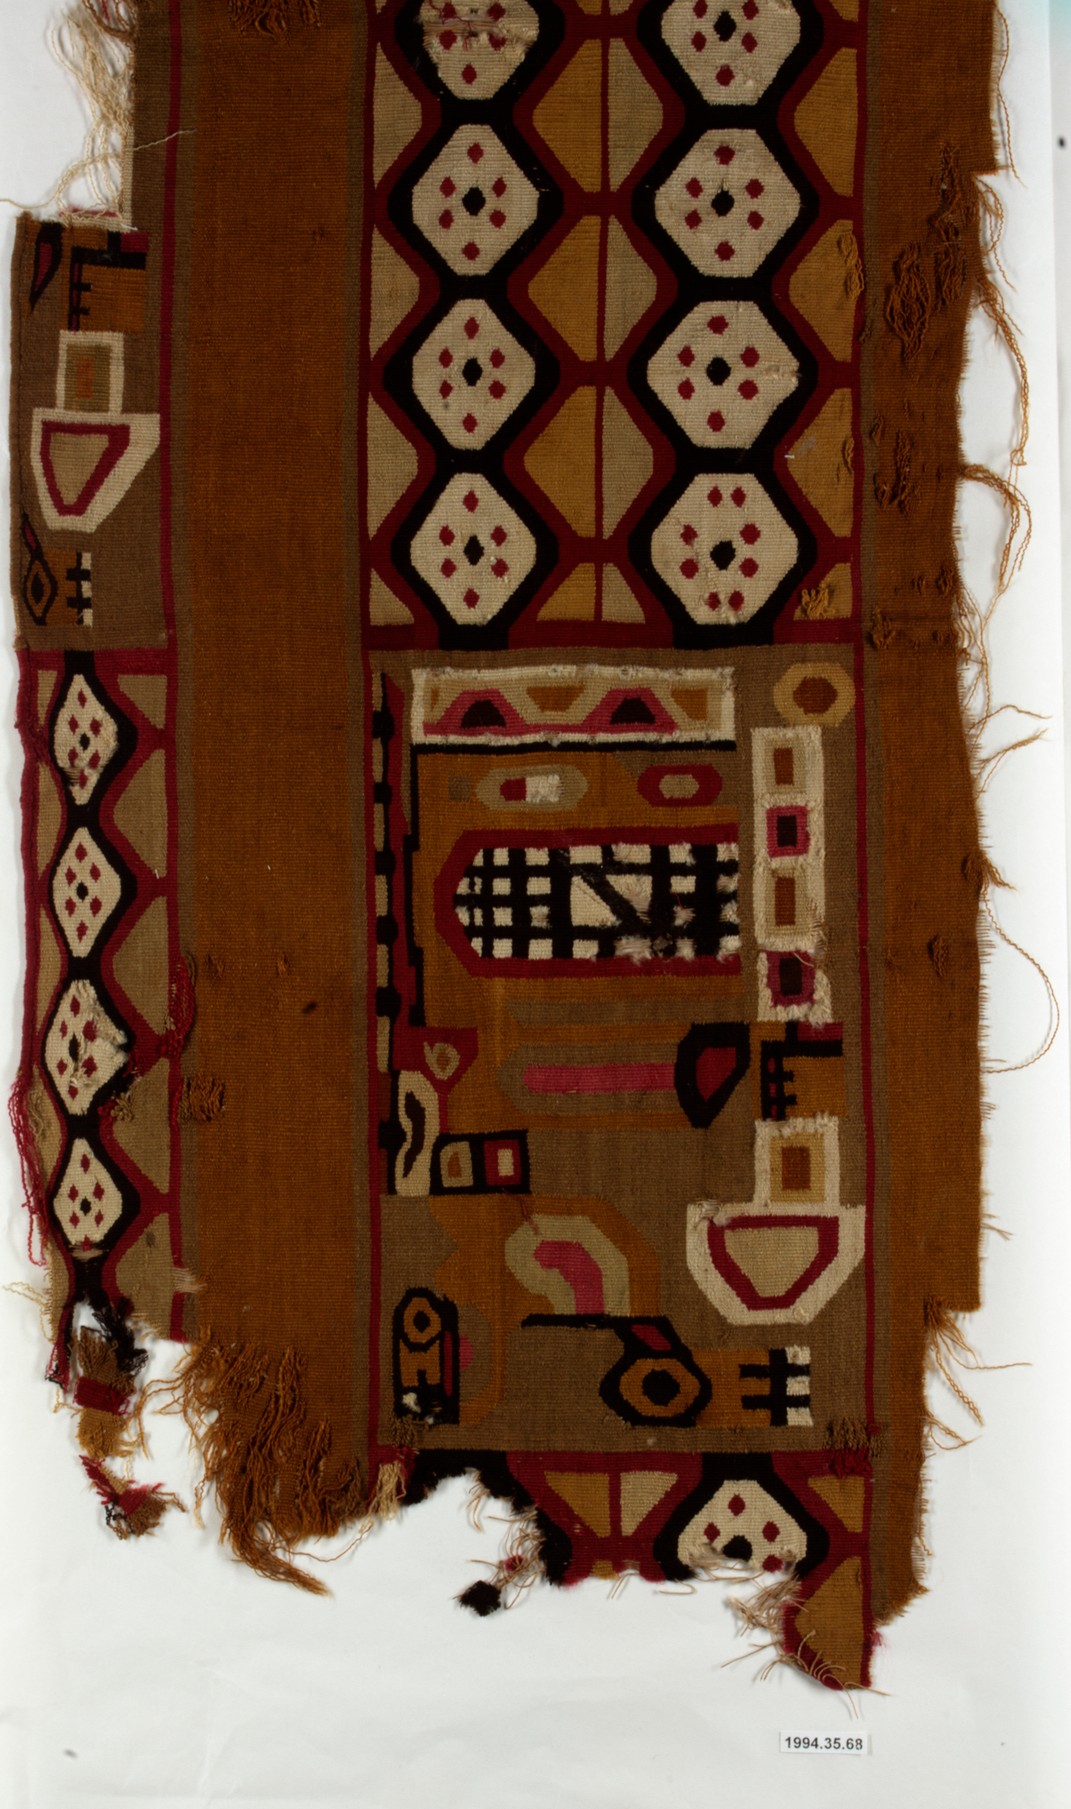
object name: tunic fragment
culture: peruvian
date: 601-1000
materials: animal fiber, cotton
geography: peru